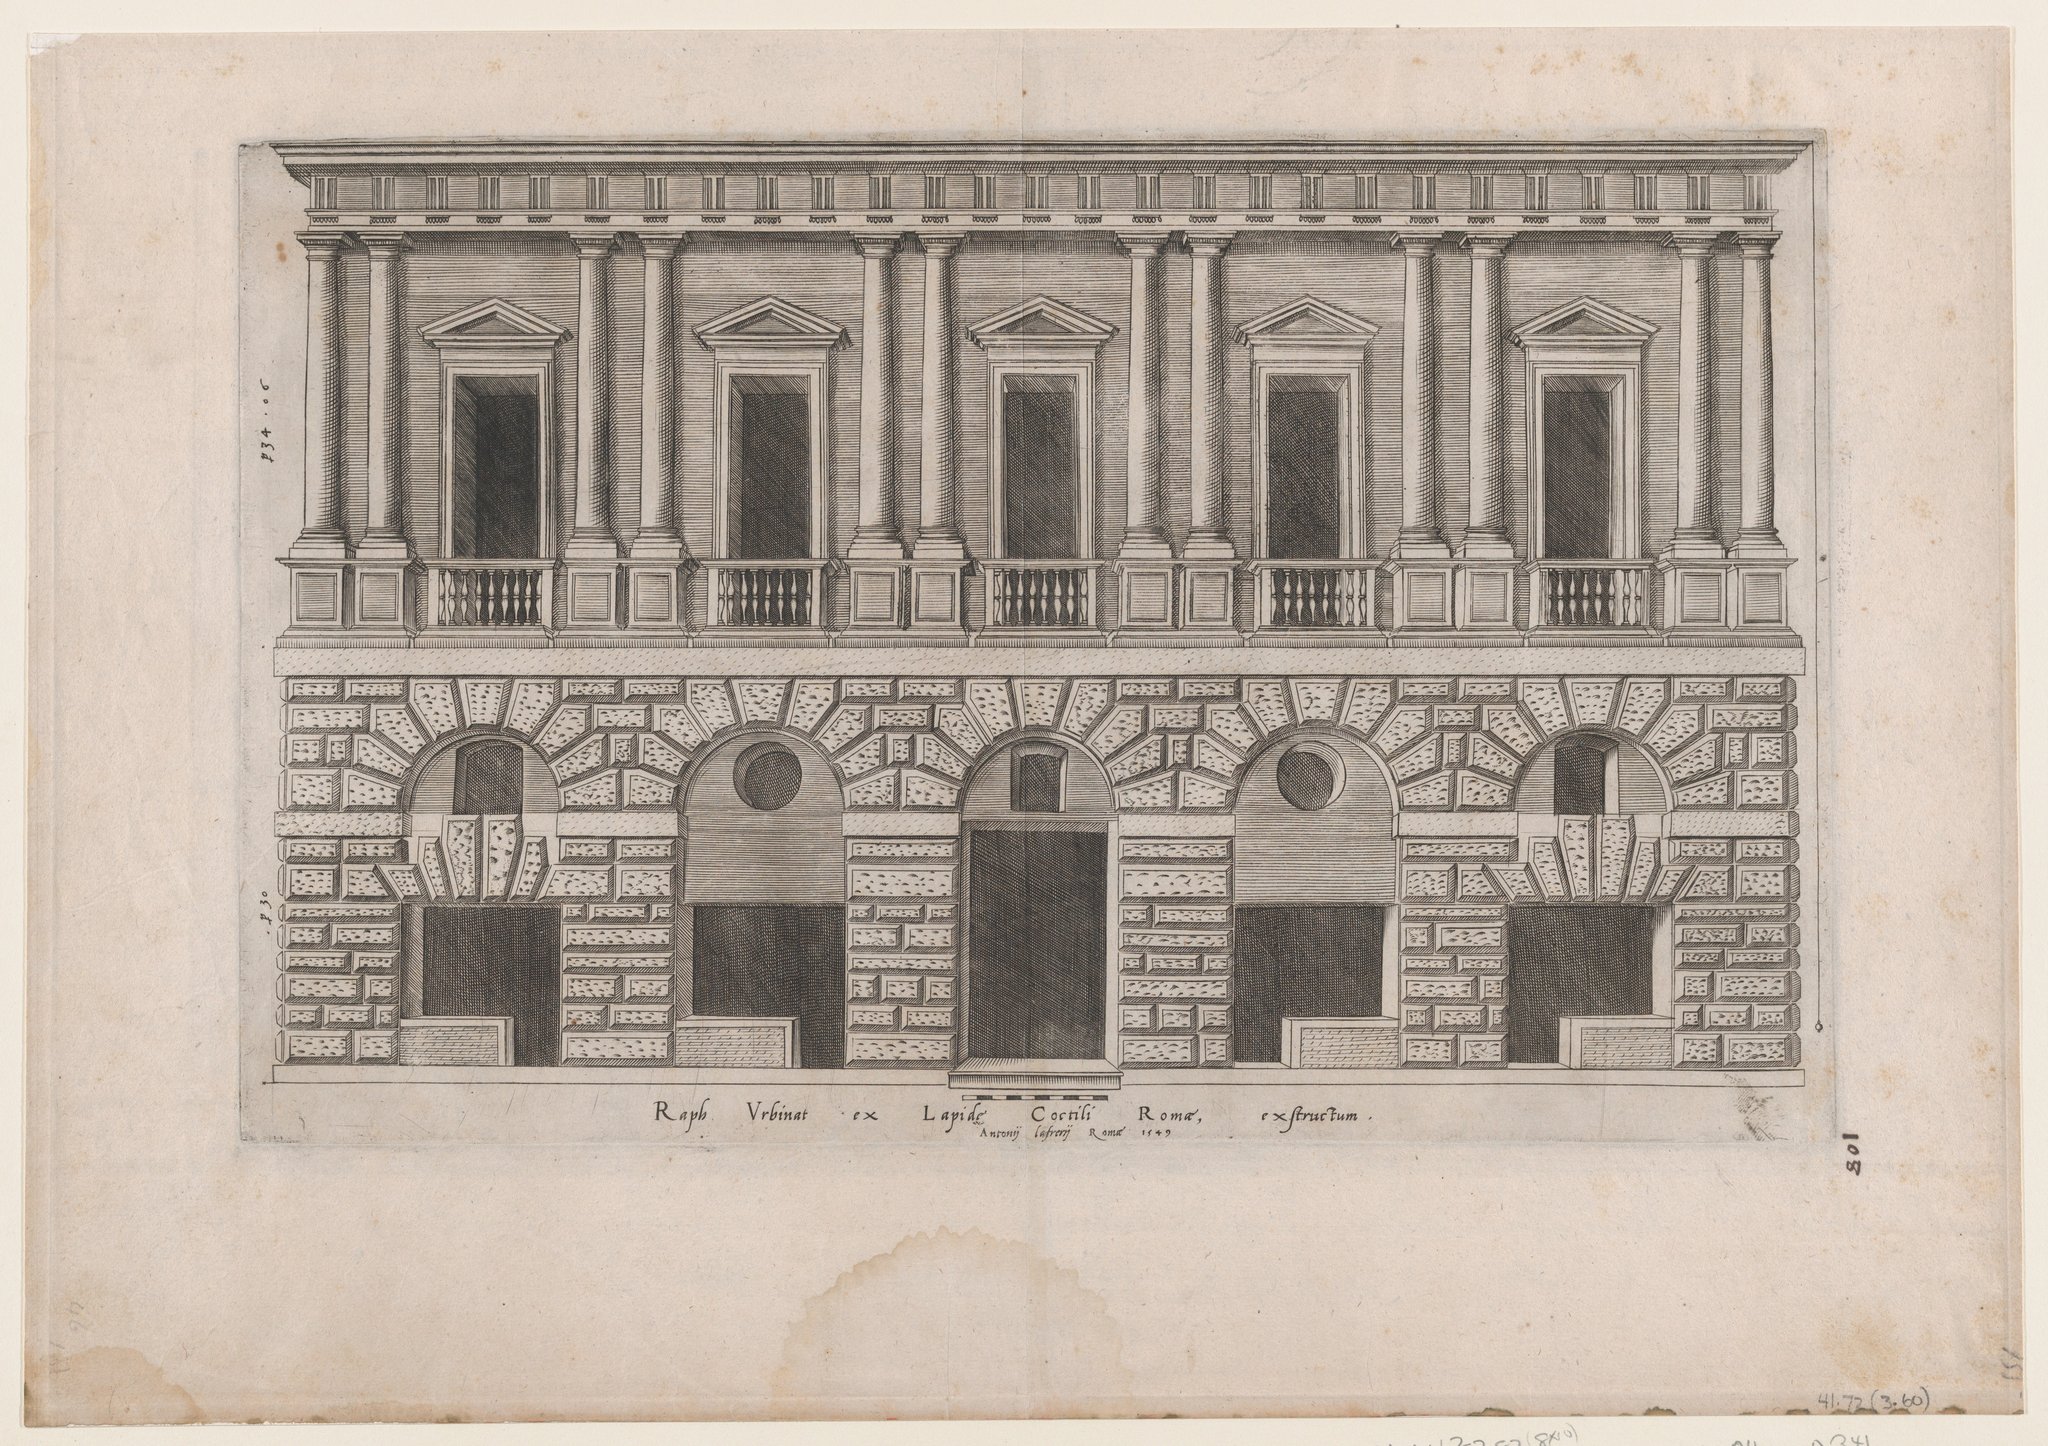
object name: print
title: House of Raphael, from "Speculum Romanae Magnificentiae"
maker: Anonymous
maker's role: artist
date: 1549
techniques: engraving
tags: architecture,buildings,rome